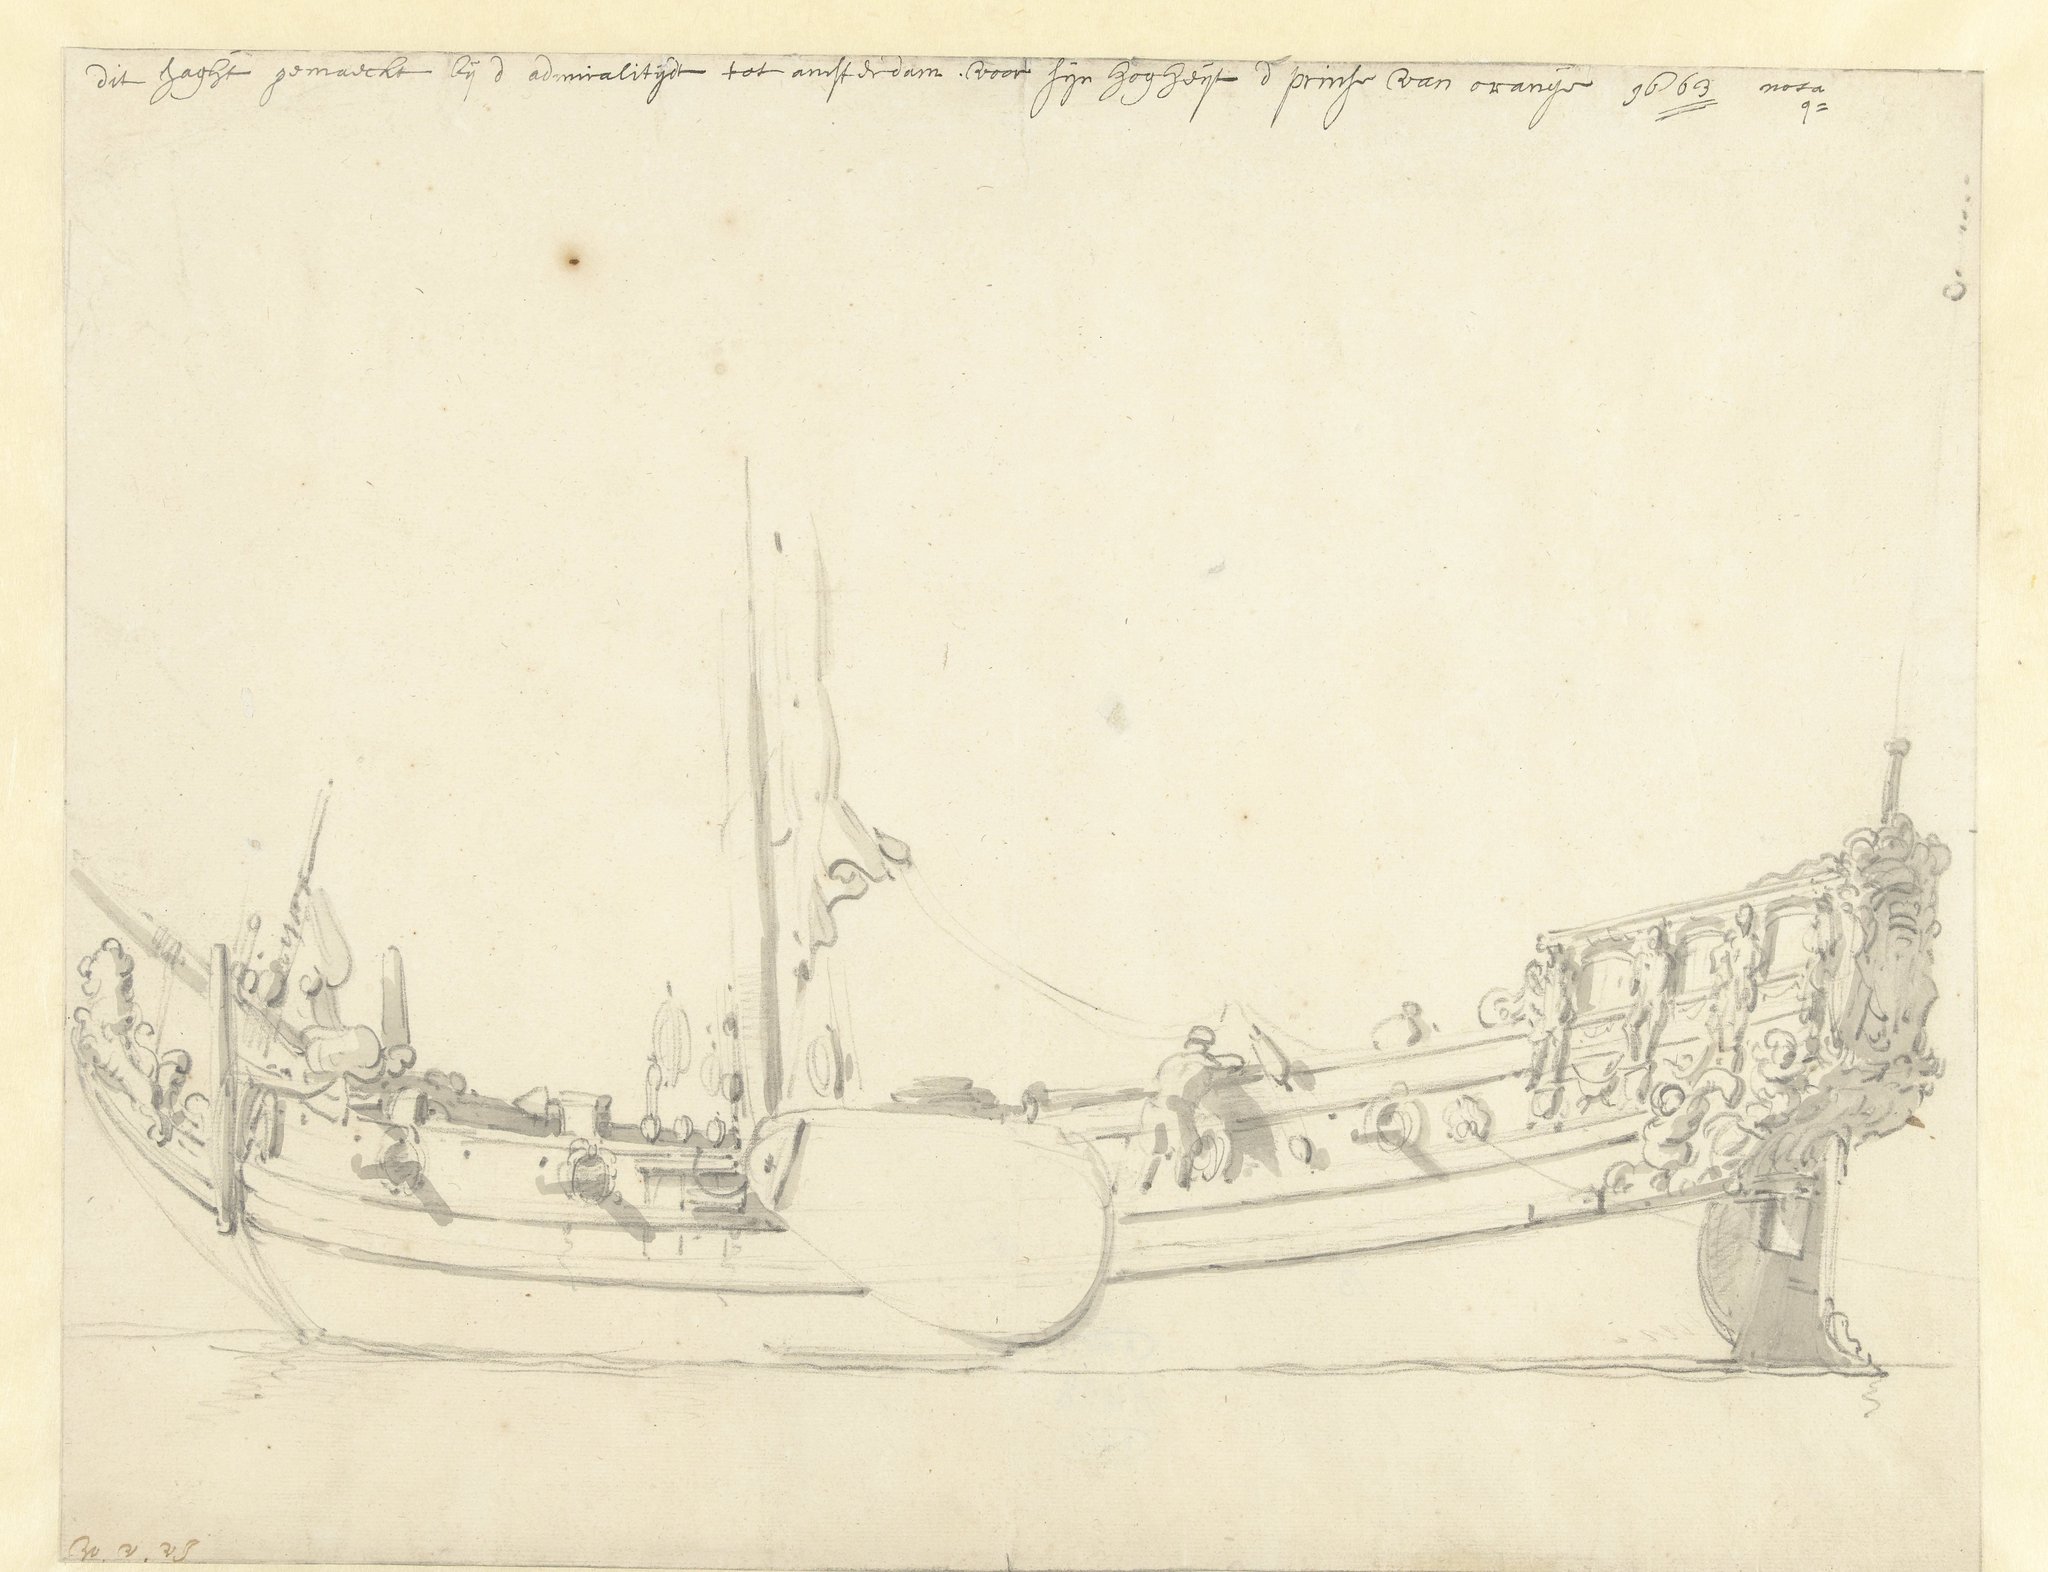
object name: drawing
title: Een jacht gebouwd voor de prins van Oranje-Nassau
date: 1663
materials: paper, pencil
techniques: brush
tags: sailing-ship, sailing-boat (with name), amsterdam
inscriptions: annotation: ‘Dit jaght gemaeckt bij d'admiralitijdt tot amsterdam voor sijn hogheijt d prinse van Oranje 1663.’